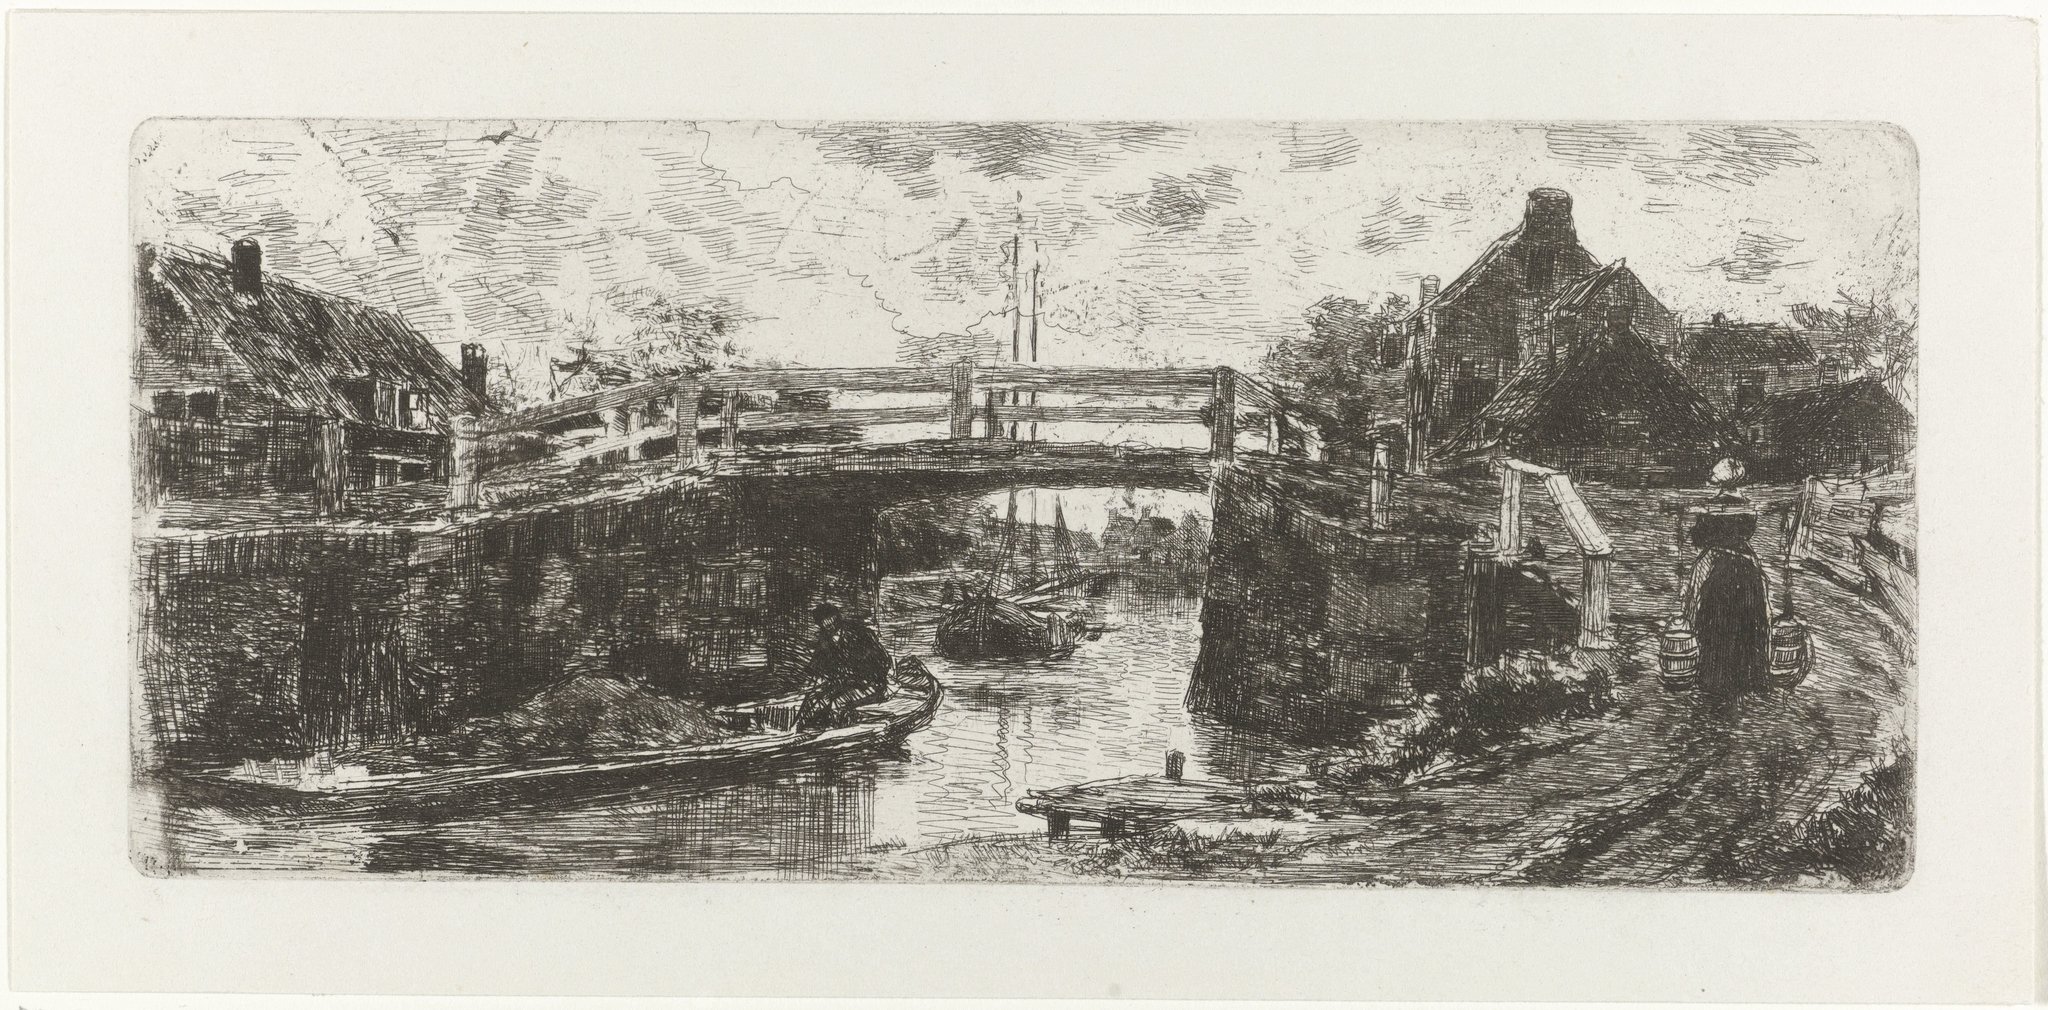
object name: print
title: Vaart met brug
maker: jacob maris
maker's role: draughtsman, painter, print maker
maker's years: 1837-1899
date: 1847-1899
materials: paper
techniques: etching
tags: carrying something with yoke, landscape with bridge, viaduct or aqueduct (+ city(-scape) with figures, staffage)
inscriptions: collector's mark: Lugt 2228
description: Een houten brug over een vaart. Rechts op een pad een melkmeid met emmers aan een juk.